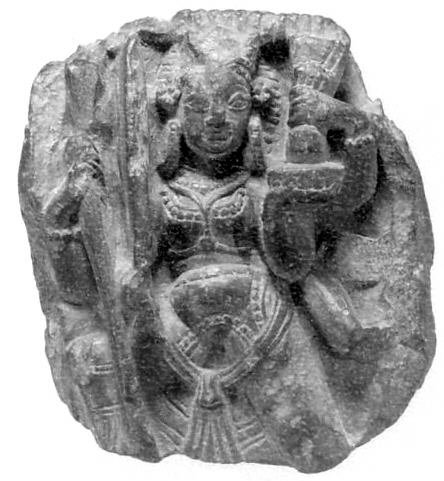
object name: stele fragment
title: Fragment of a Small Stele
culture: kashmiri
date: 501-700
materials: stone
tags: kashmir